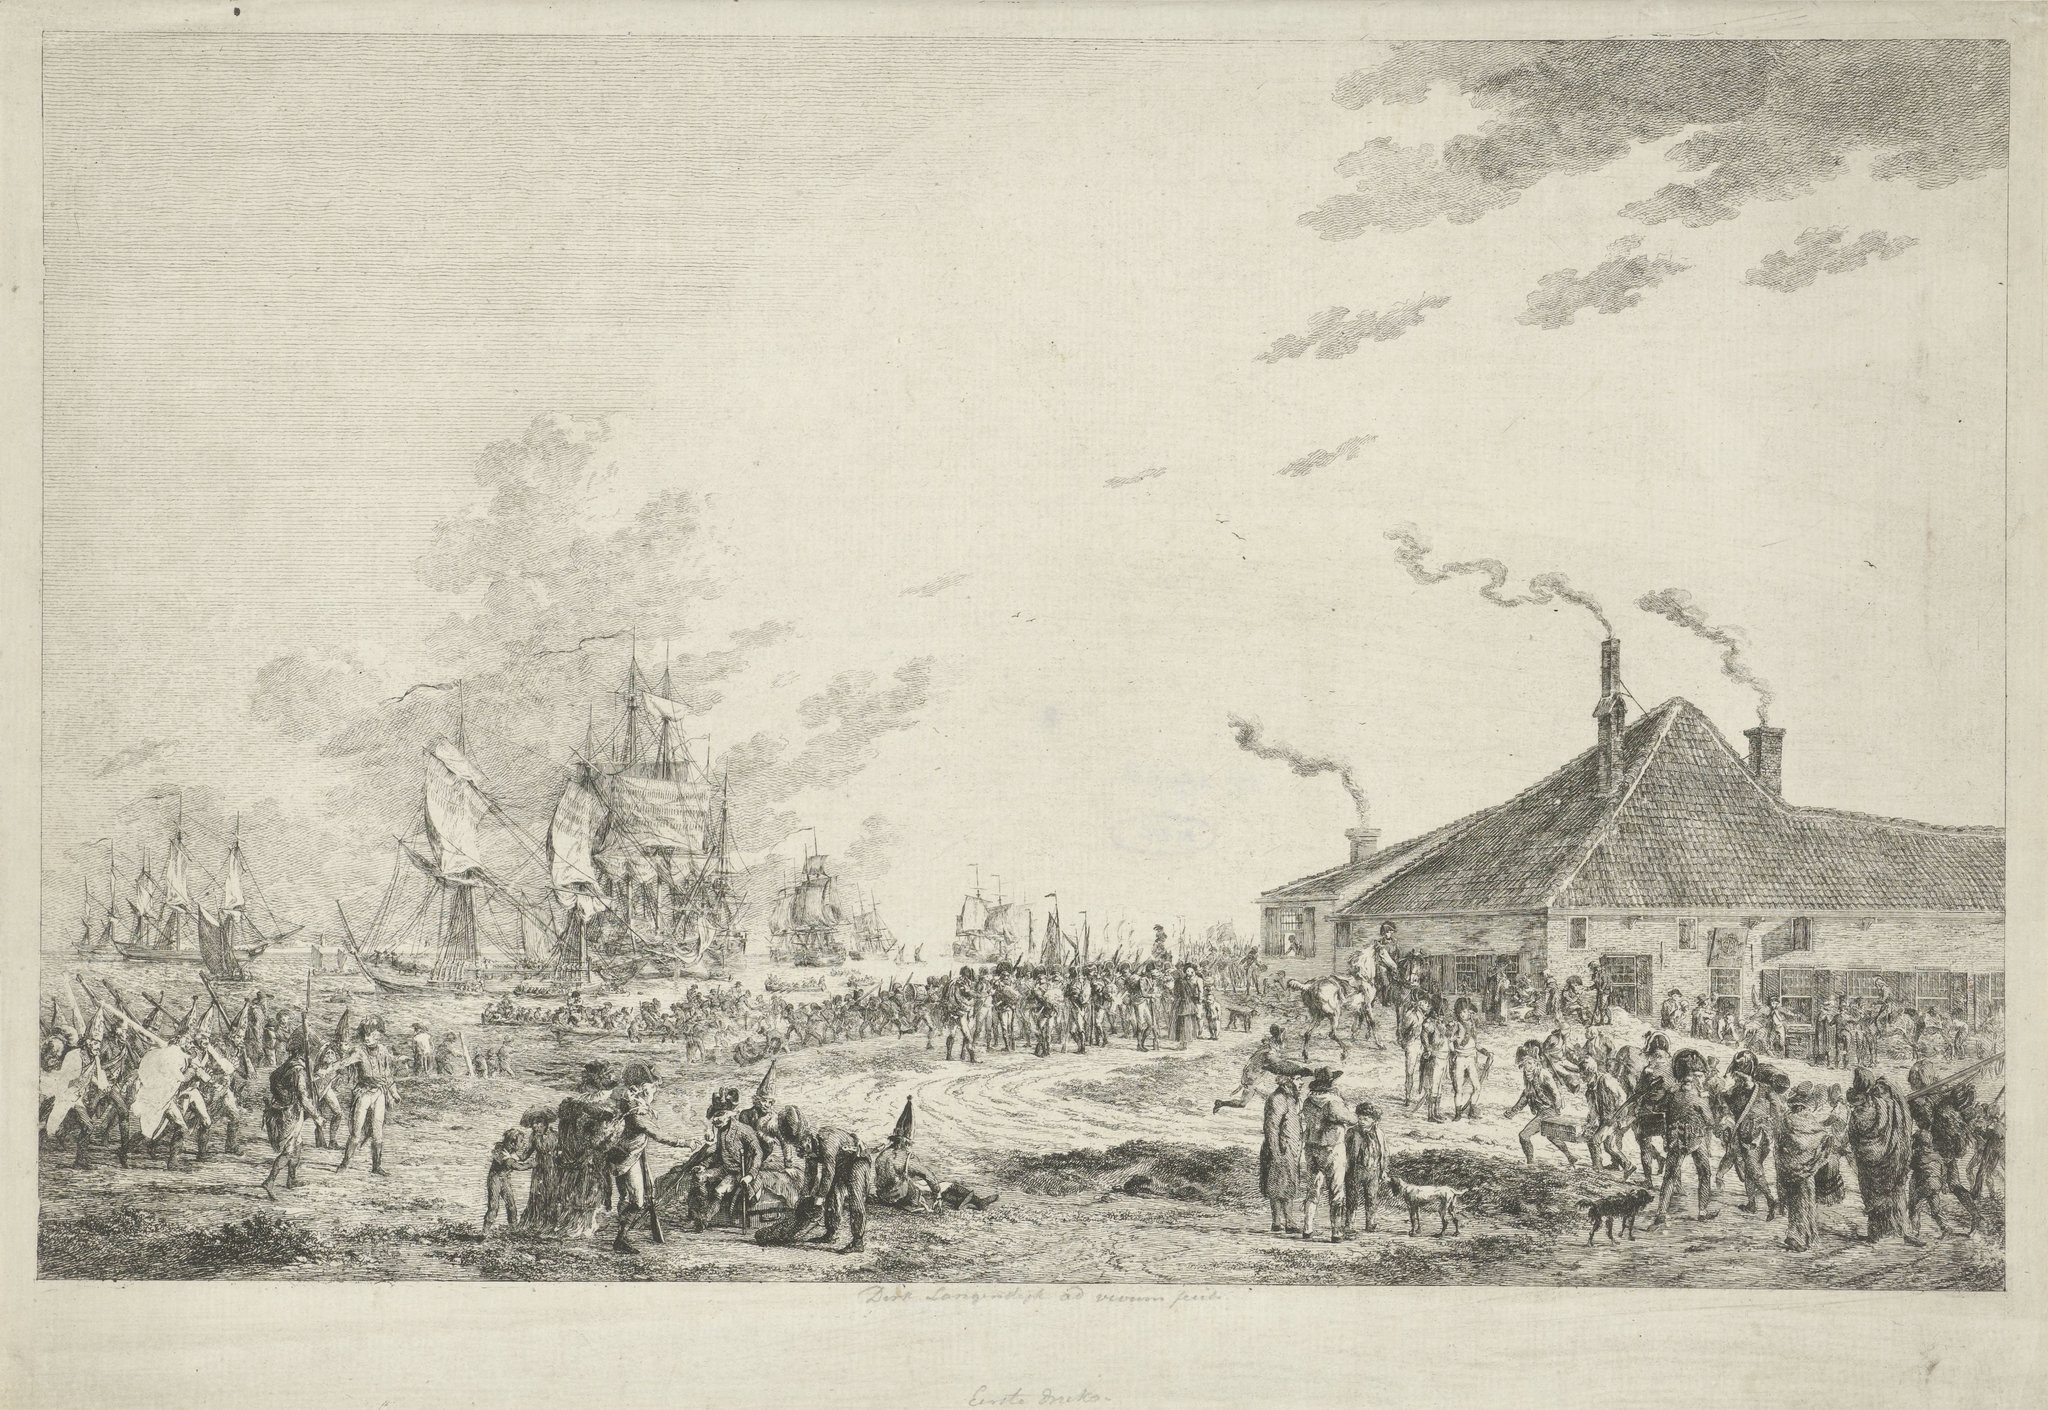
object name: print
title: Vertrek van de Engelse en Russische troepen uit Den Helder, 1799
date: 1799-1801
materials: paper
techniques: etching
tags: navy (+ after the battle), navy (+ sailing-ships), beach, den helder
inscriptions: collector's mark: Lugt 2228, inscription: ‘Dirk Langendijk ad vivum fecit’, collector's mark: Lugt 151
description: Engelse en Russische troepen maken zich op voor het vertrek uit Den Helder, 1799. Strandgezicht met militairen. Zeilschepen liggen voor anker, roeiboten varen af en aan.